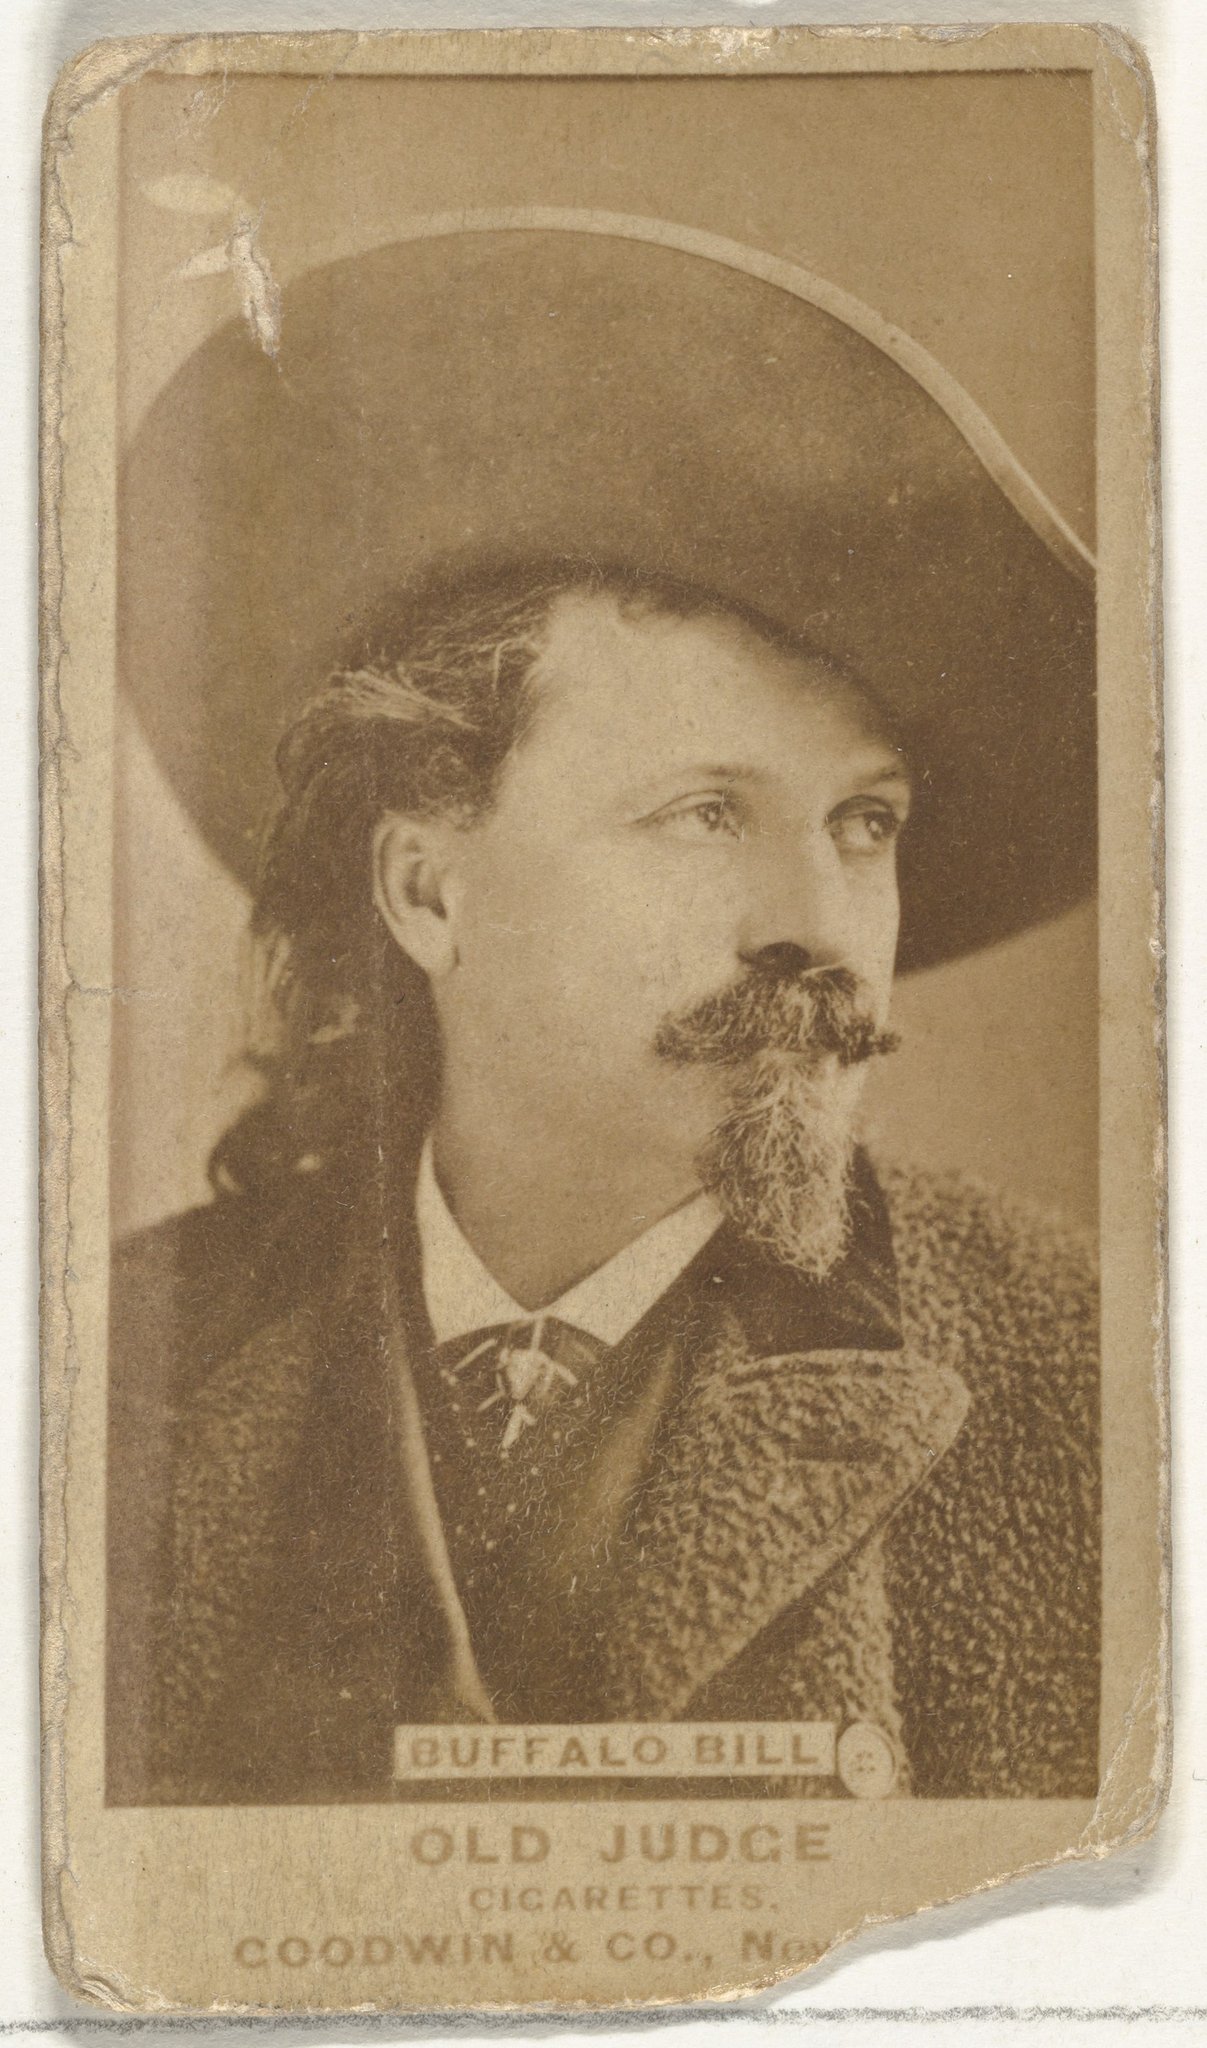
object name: photograph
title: Buffalo Bill, from the Celebrities and Prizefighters series (N174) for Old Judge Cigarettes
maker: goodwin & company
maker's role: publisher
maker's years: 1850-1950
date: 1887-1888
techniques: albumen silver print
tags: men,portraits